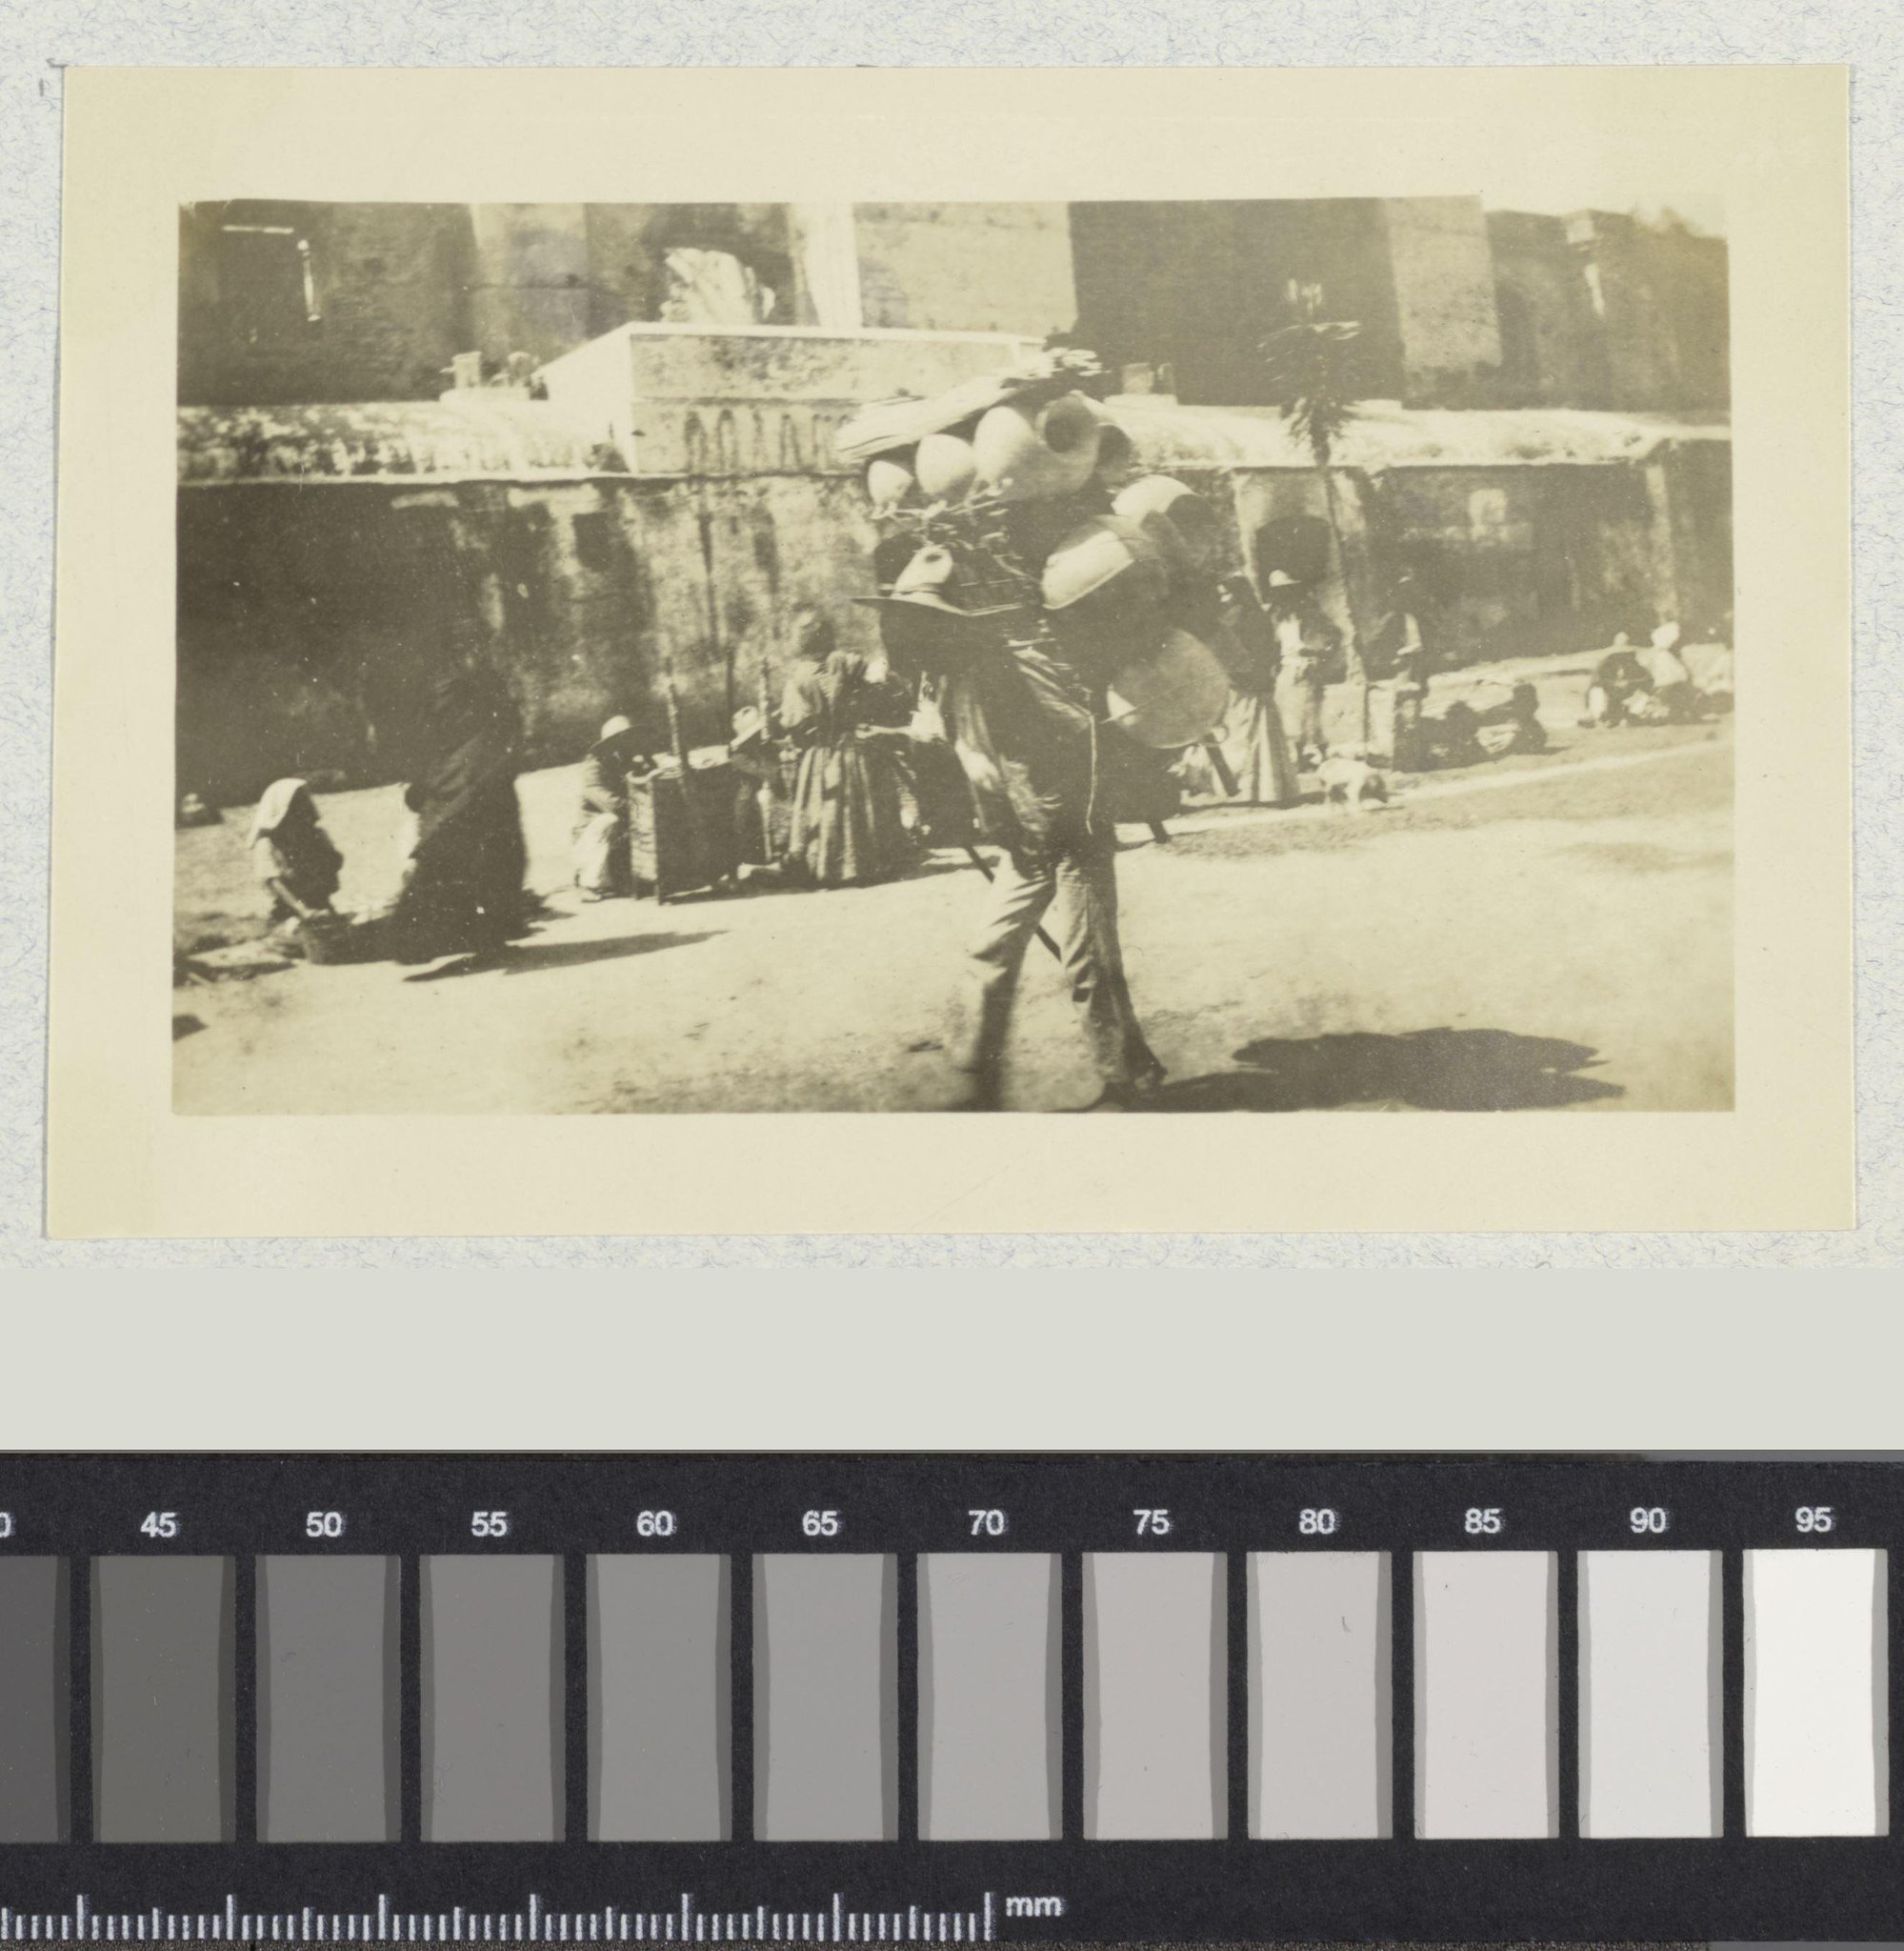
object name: photograph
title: Markt van Antigua Guatemala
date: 1909-1912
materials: photographic support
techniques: photography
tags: market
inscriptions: inscription: ‘Antigua’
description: Zwaar beladen handelaar op de markt van Antigua Guatemala, september 1912. Onderdeel van het fotoalbum van de familie Boom-Gonggrijp in Suriname en Curaçao.